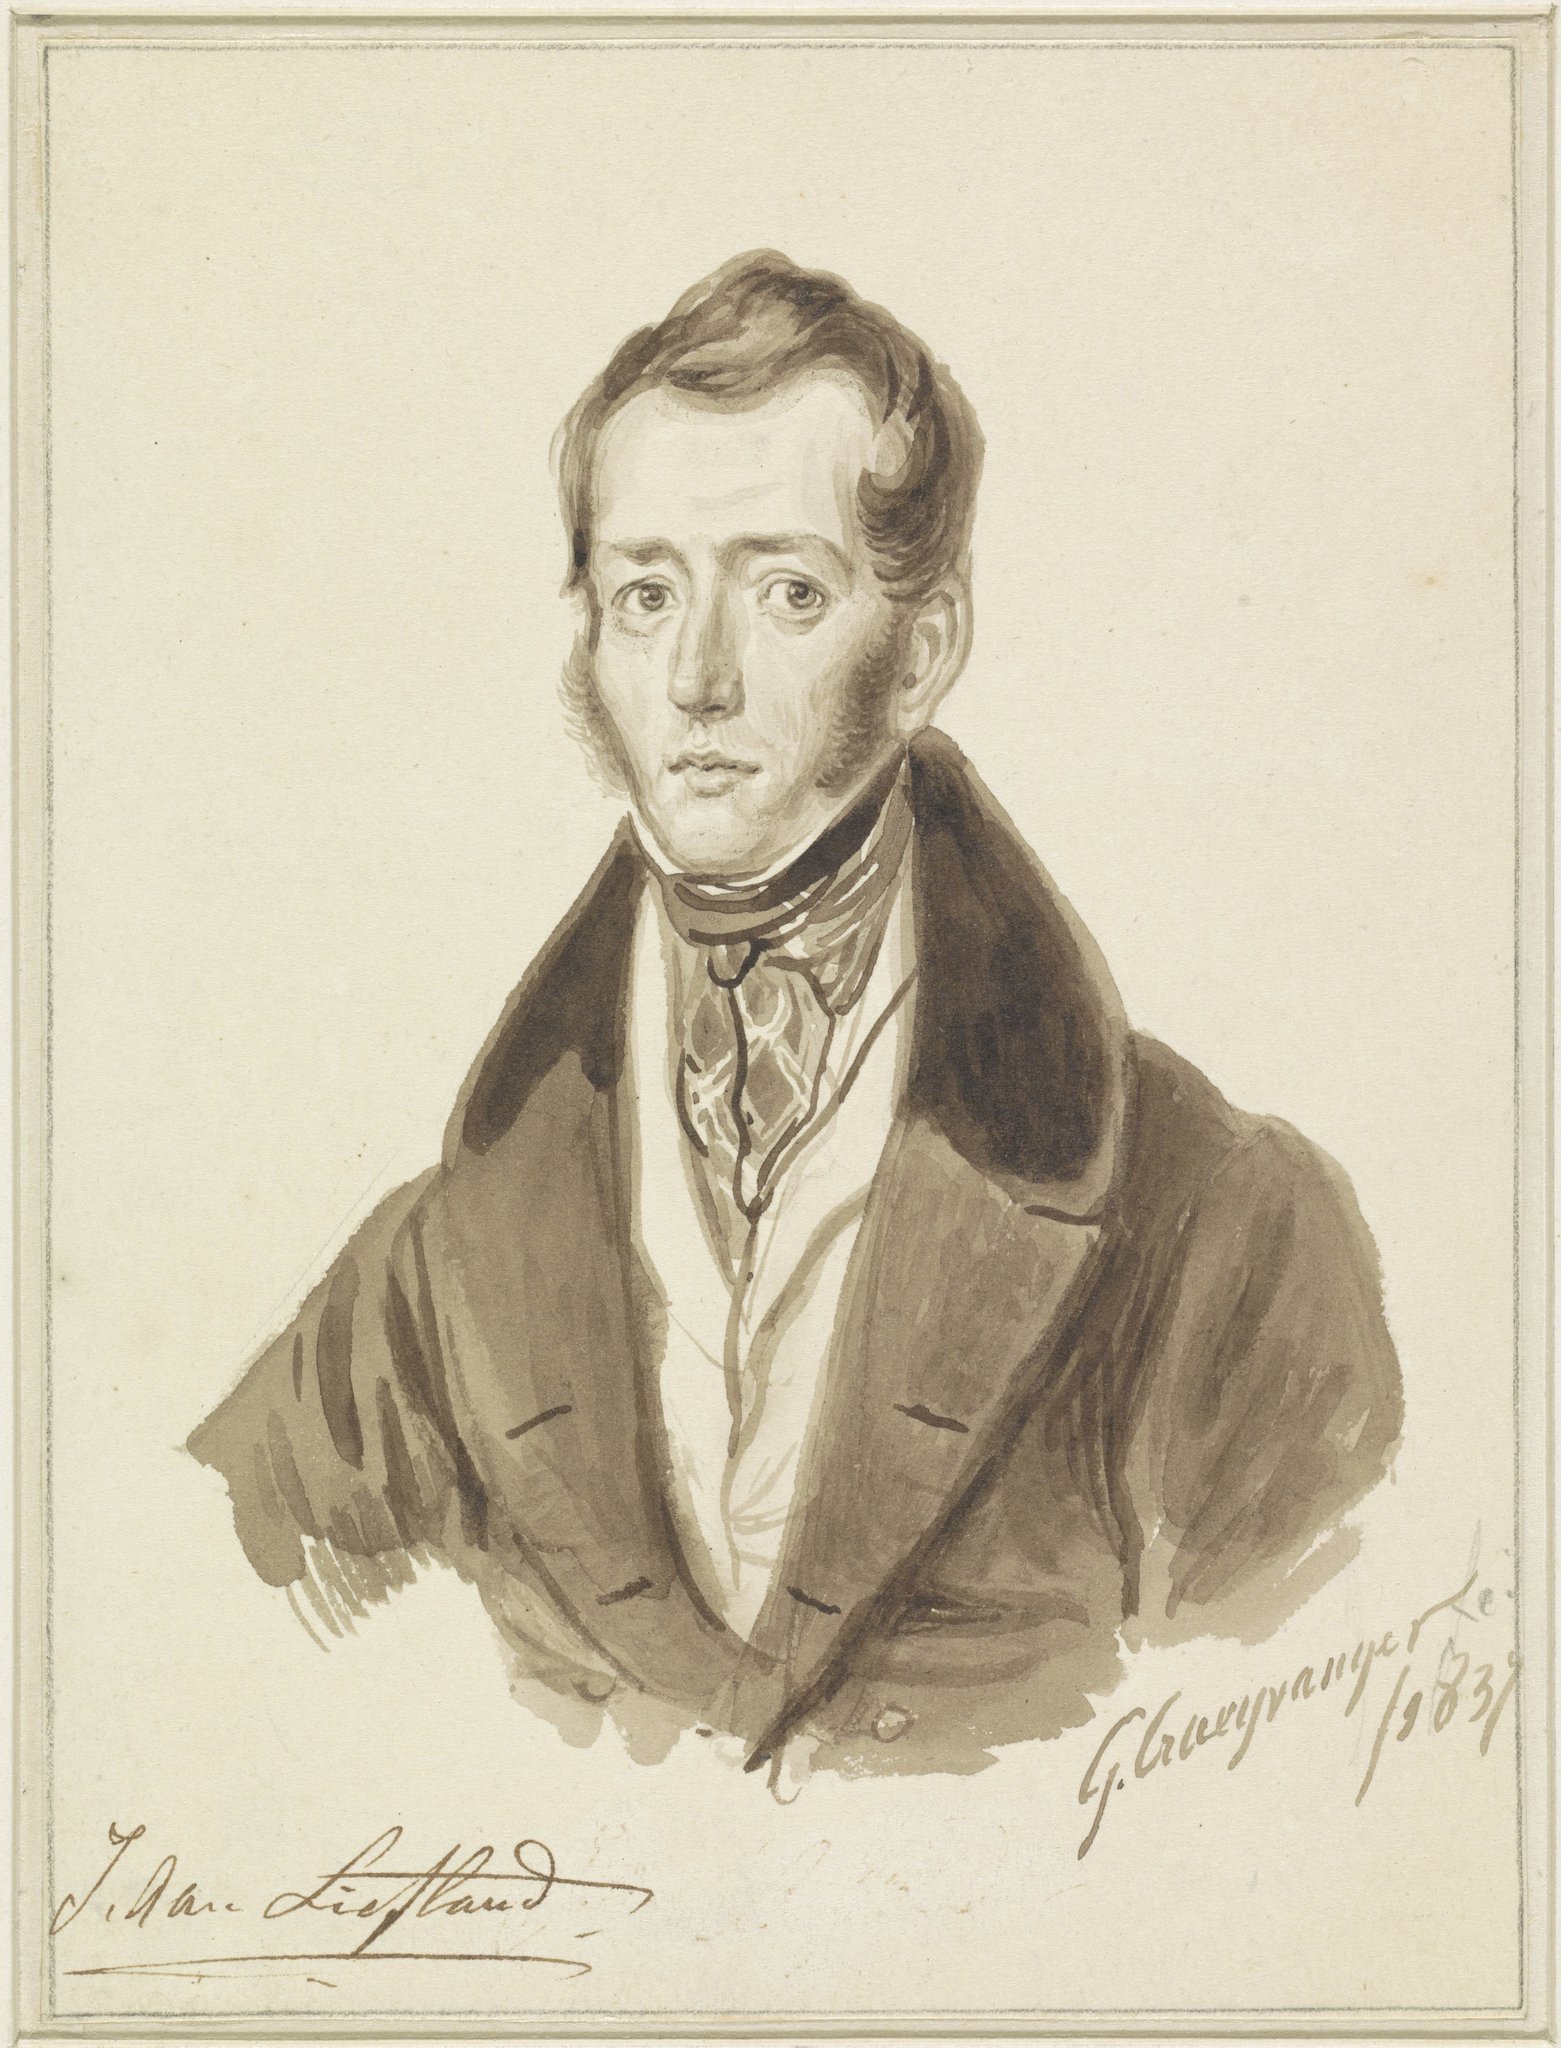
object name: drawing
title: Portret van Joannes van Liefland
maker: gijsbertus craeyvanger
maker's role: draughtsman, print maker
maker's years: 1810-1895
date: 1837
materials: paper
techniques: brush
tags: joannes van liefland, historical persons, portrait, self-portrait of artist